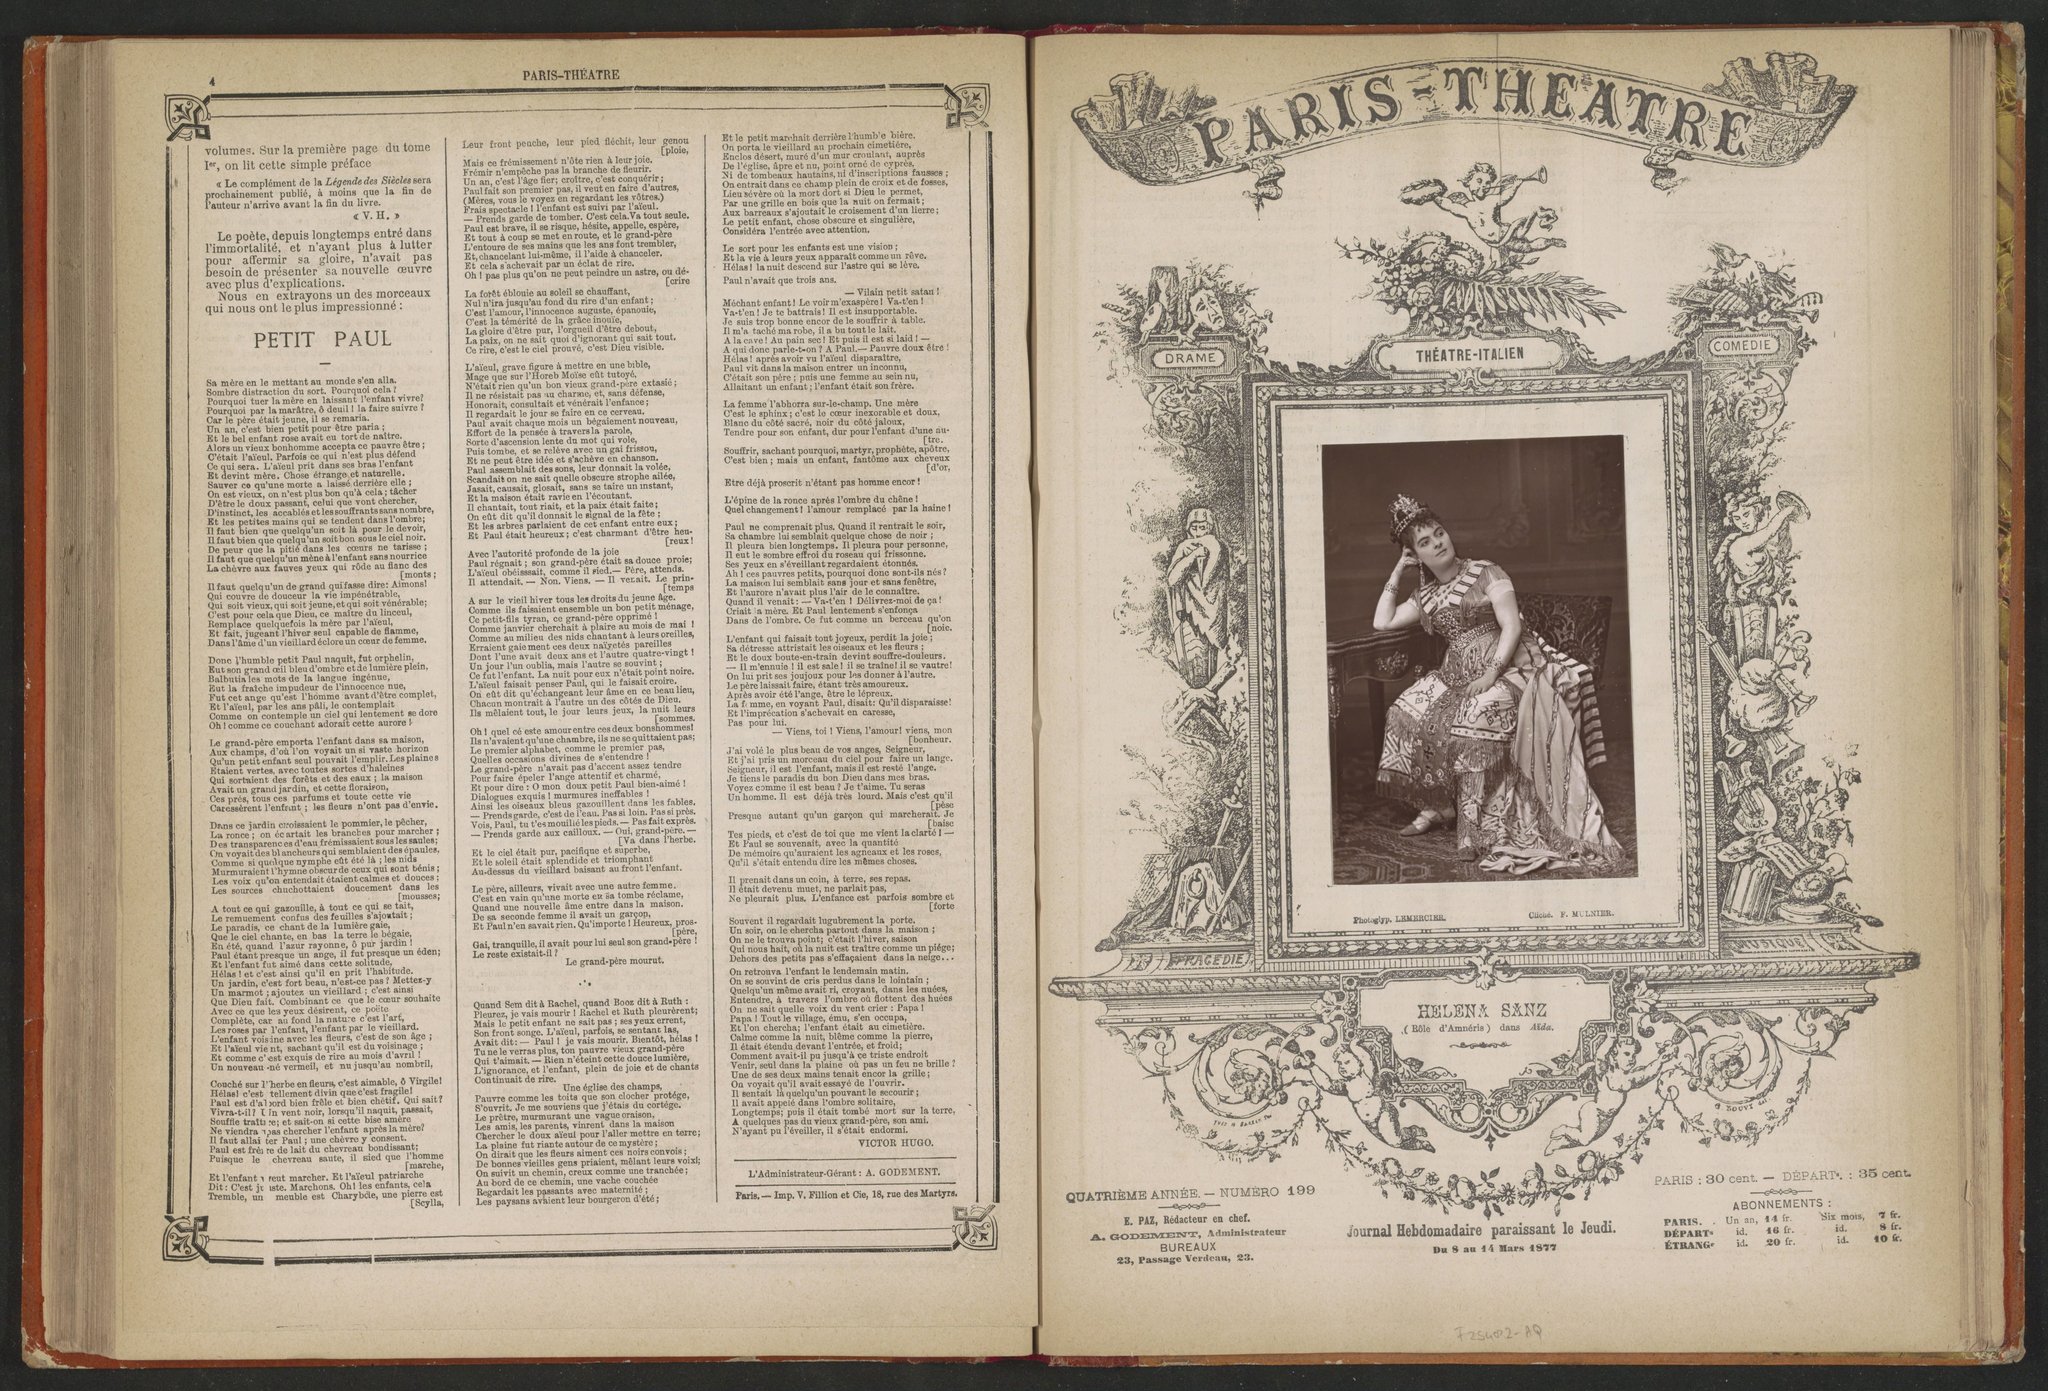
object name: page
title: Portret van Elena Sanz als Amneris in Aïda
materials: paper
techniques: woodburytype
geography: paris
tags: portrait of opera-singer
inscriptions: number: ‘Numéro 199’, inscription: ‘Journal Hebdomadaire paraissant le Jeudi, Du 8 au 14 Mars 1877’